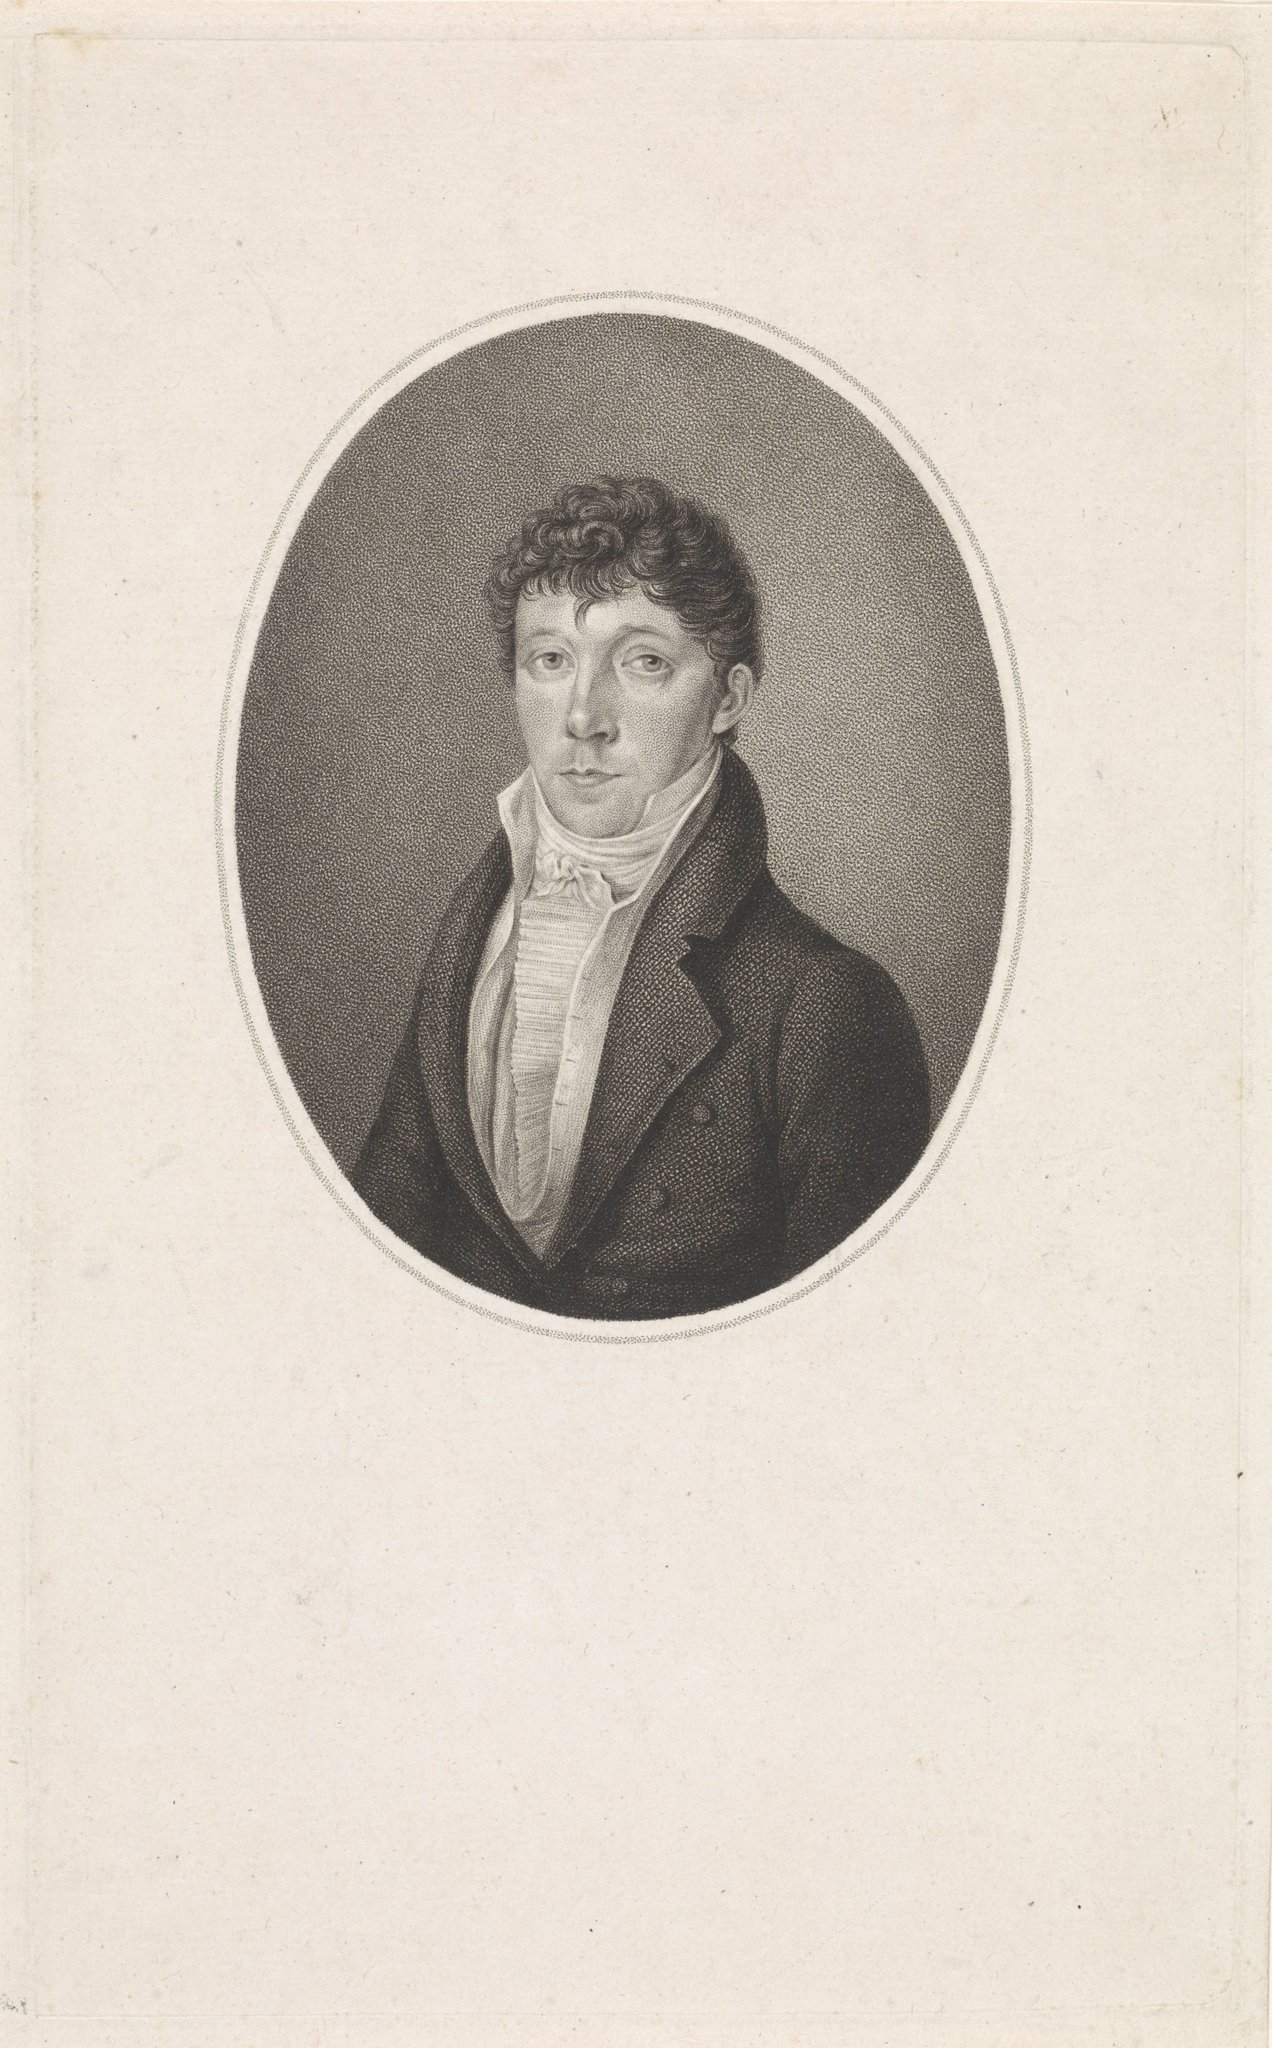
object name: print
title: Portret van Jacob Elisa Doornik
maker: willem van senus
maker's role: painter, print maker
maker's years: 1773-1851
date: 1797-1851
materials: paper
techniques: engraving, etching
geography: netherlands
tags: leiden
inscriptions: collector's mark: Lugt 2228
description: Portret van Jacob Elisa Doornik, doctor in de medicijnen.